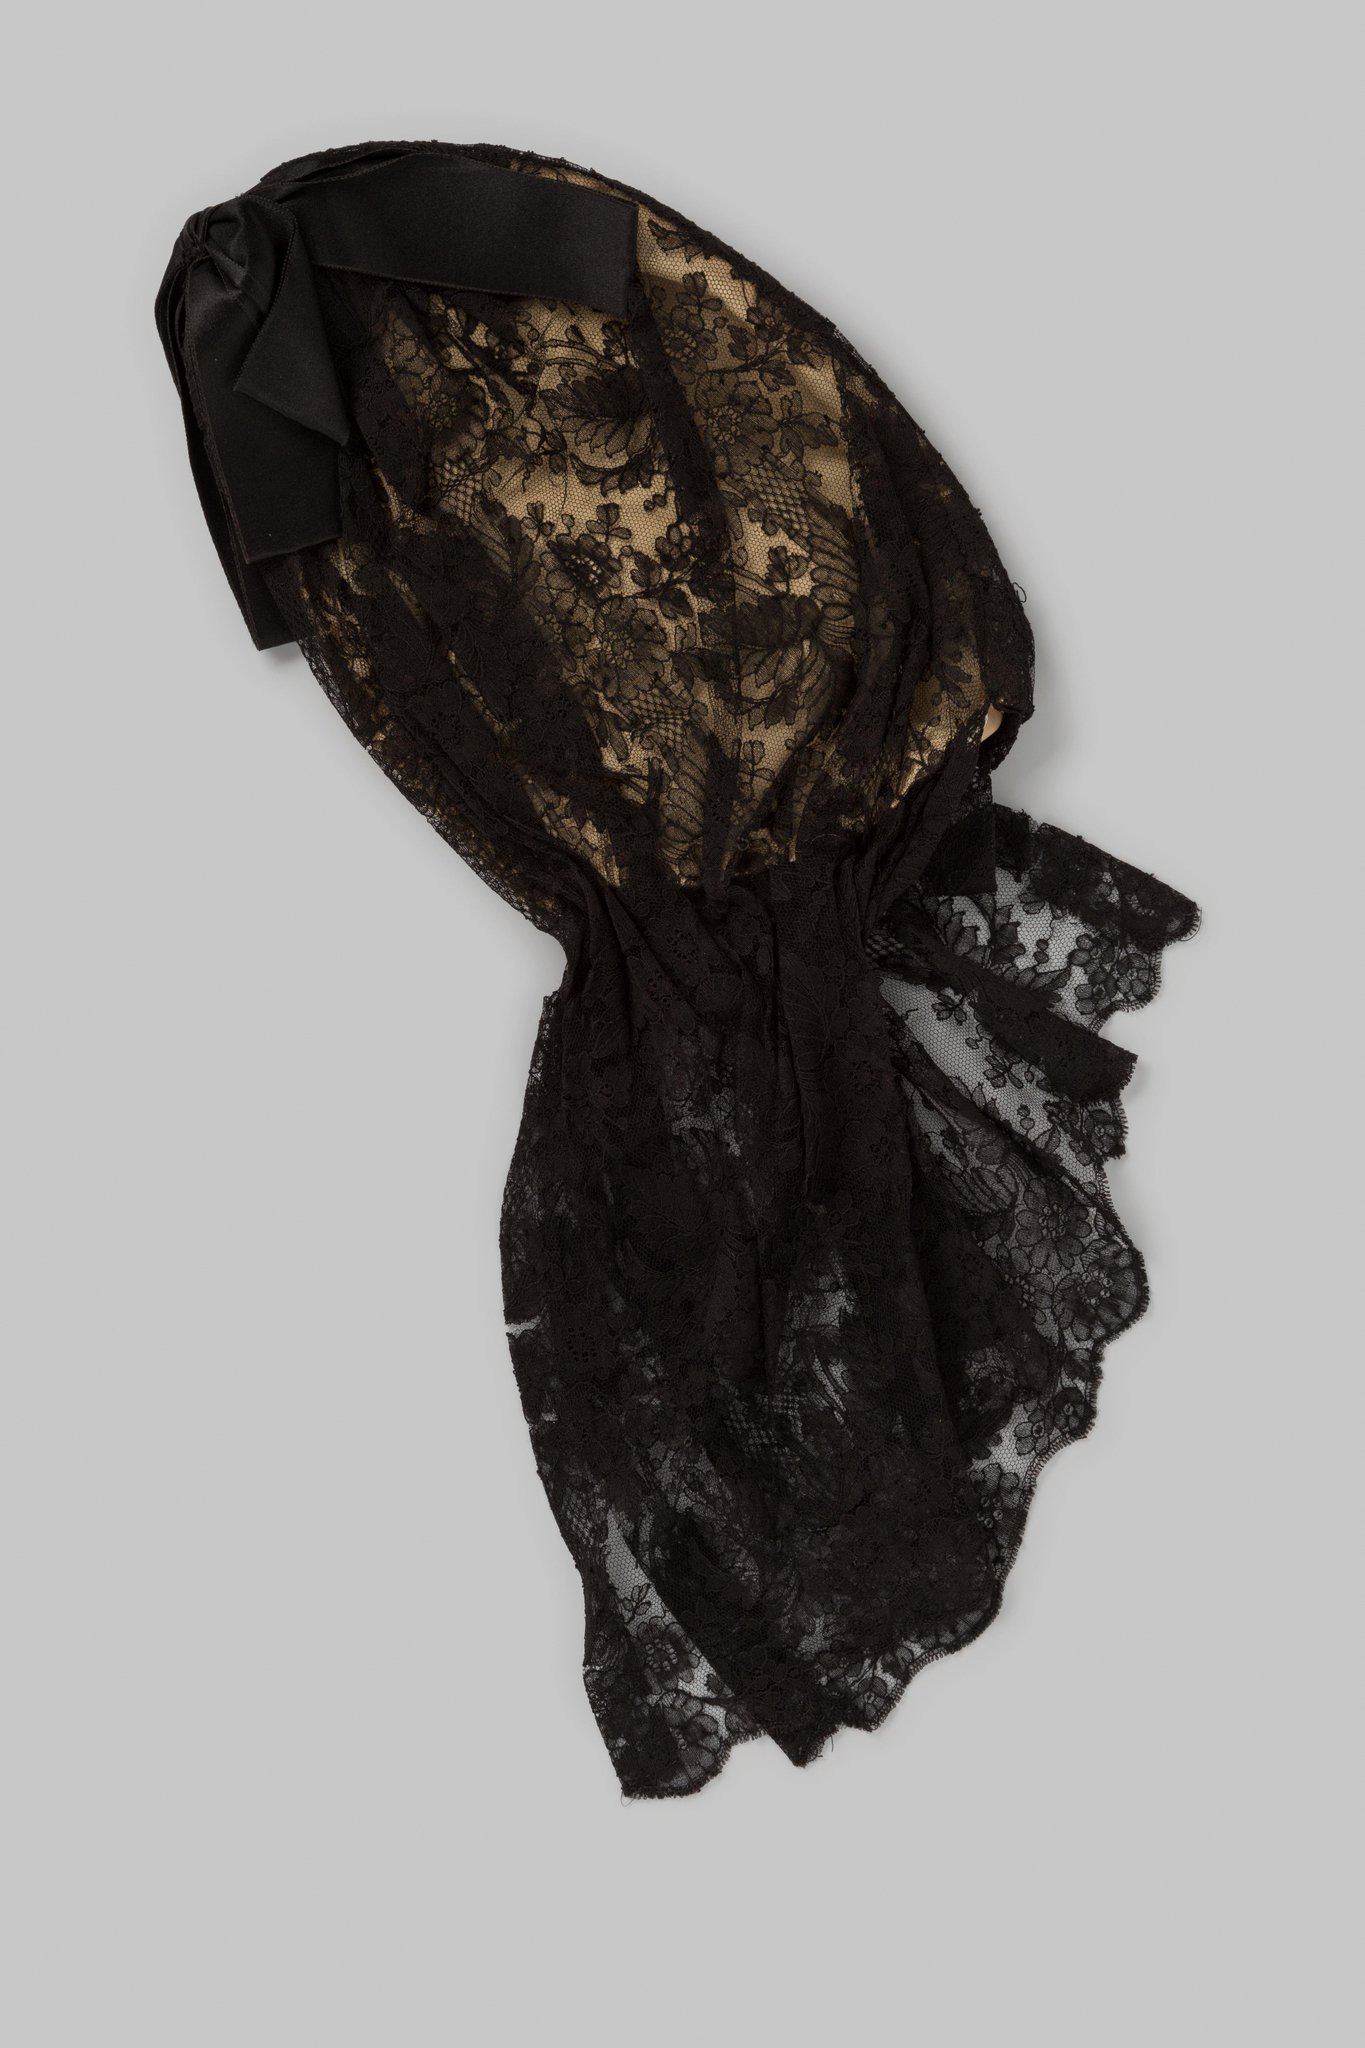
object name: cap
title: Muts van zwarte machinale kant, gevoerd met gele zijde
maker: Anonymous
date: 1800-1900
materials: textile, silk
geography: netherlands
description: Muts van zwarte machinale kant gevoerd met gele zijde. Bovenop de muts is een zwarte satijnen strik bevestigd.